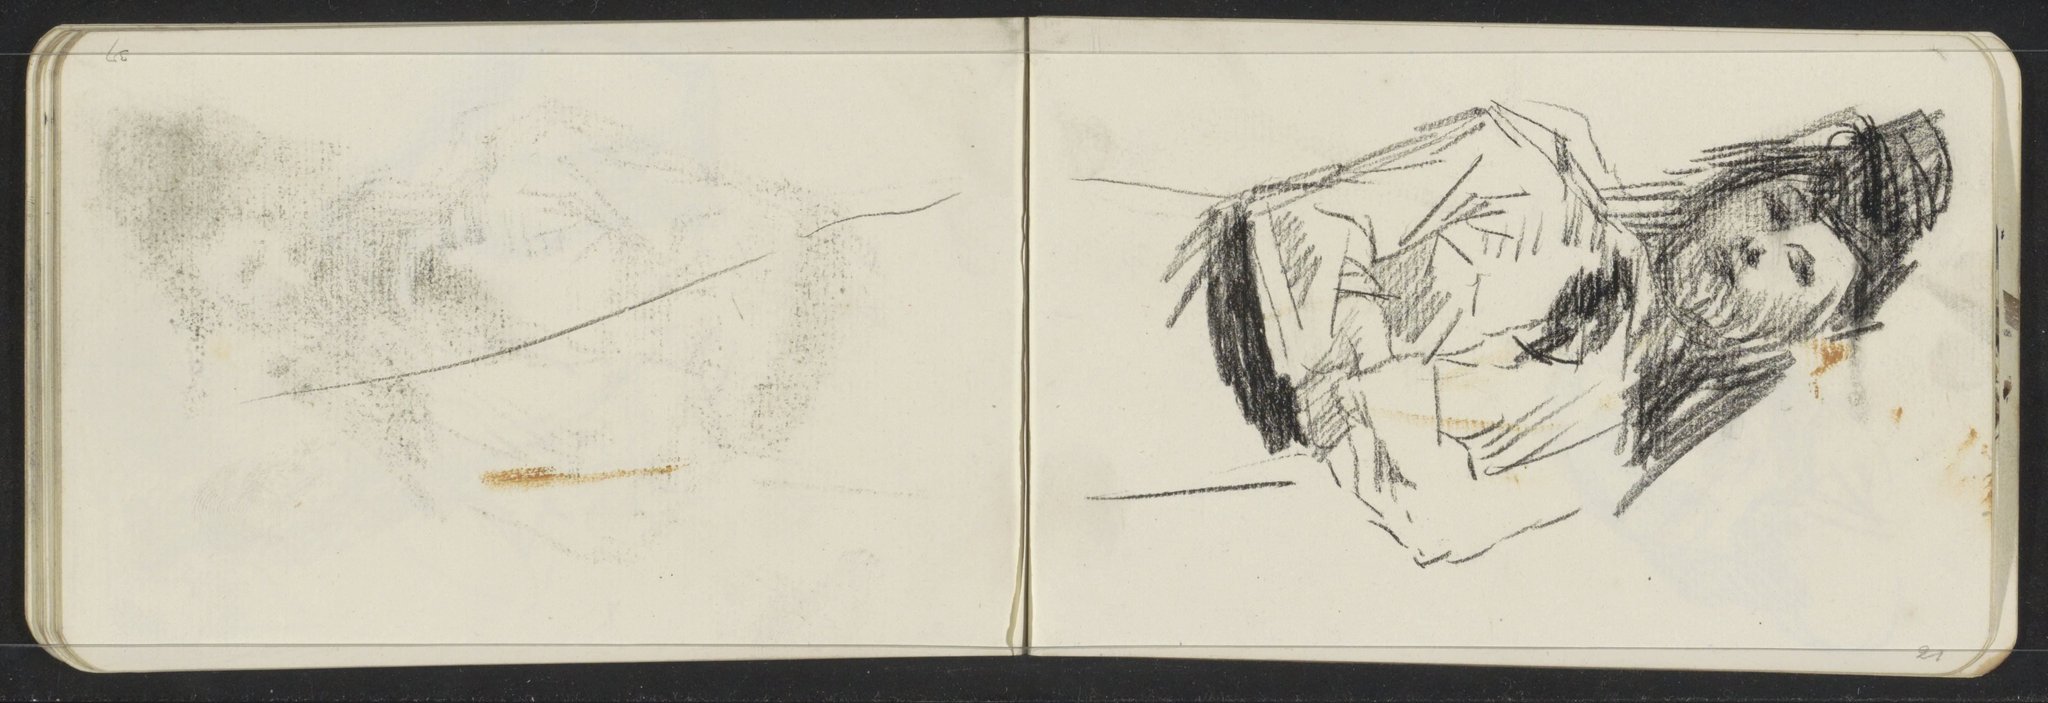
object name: sketchbook leaf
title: Staande vrouw met haar armen over elkaar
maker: isaac israels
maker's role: draughtsman, painter, print maker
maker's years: 1865-1934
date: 1875-1934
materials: chalk, paper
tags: adult woman (+ standing), arms crossed over the breast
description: Blad 20 verso en blad 21 recto uit schetsboek LXII met 28 bladen.